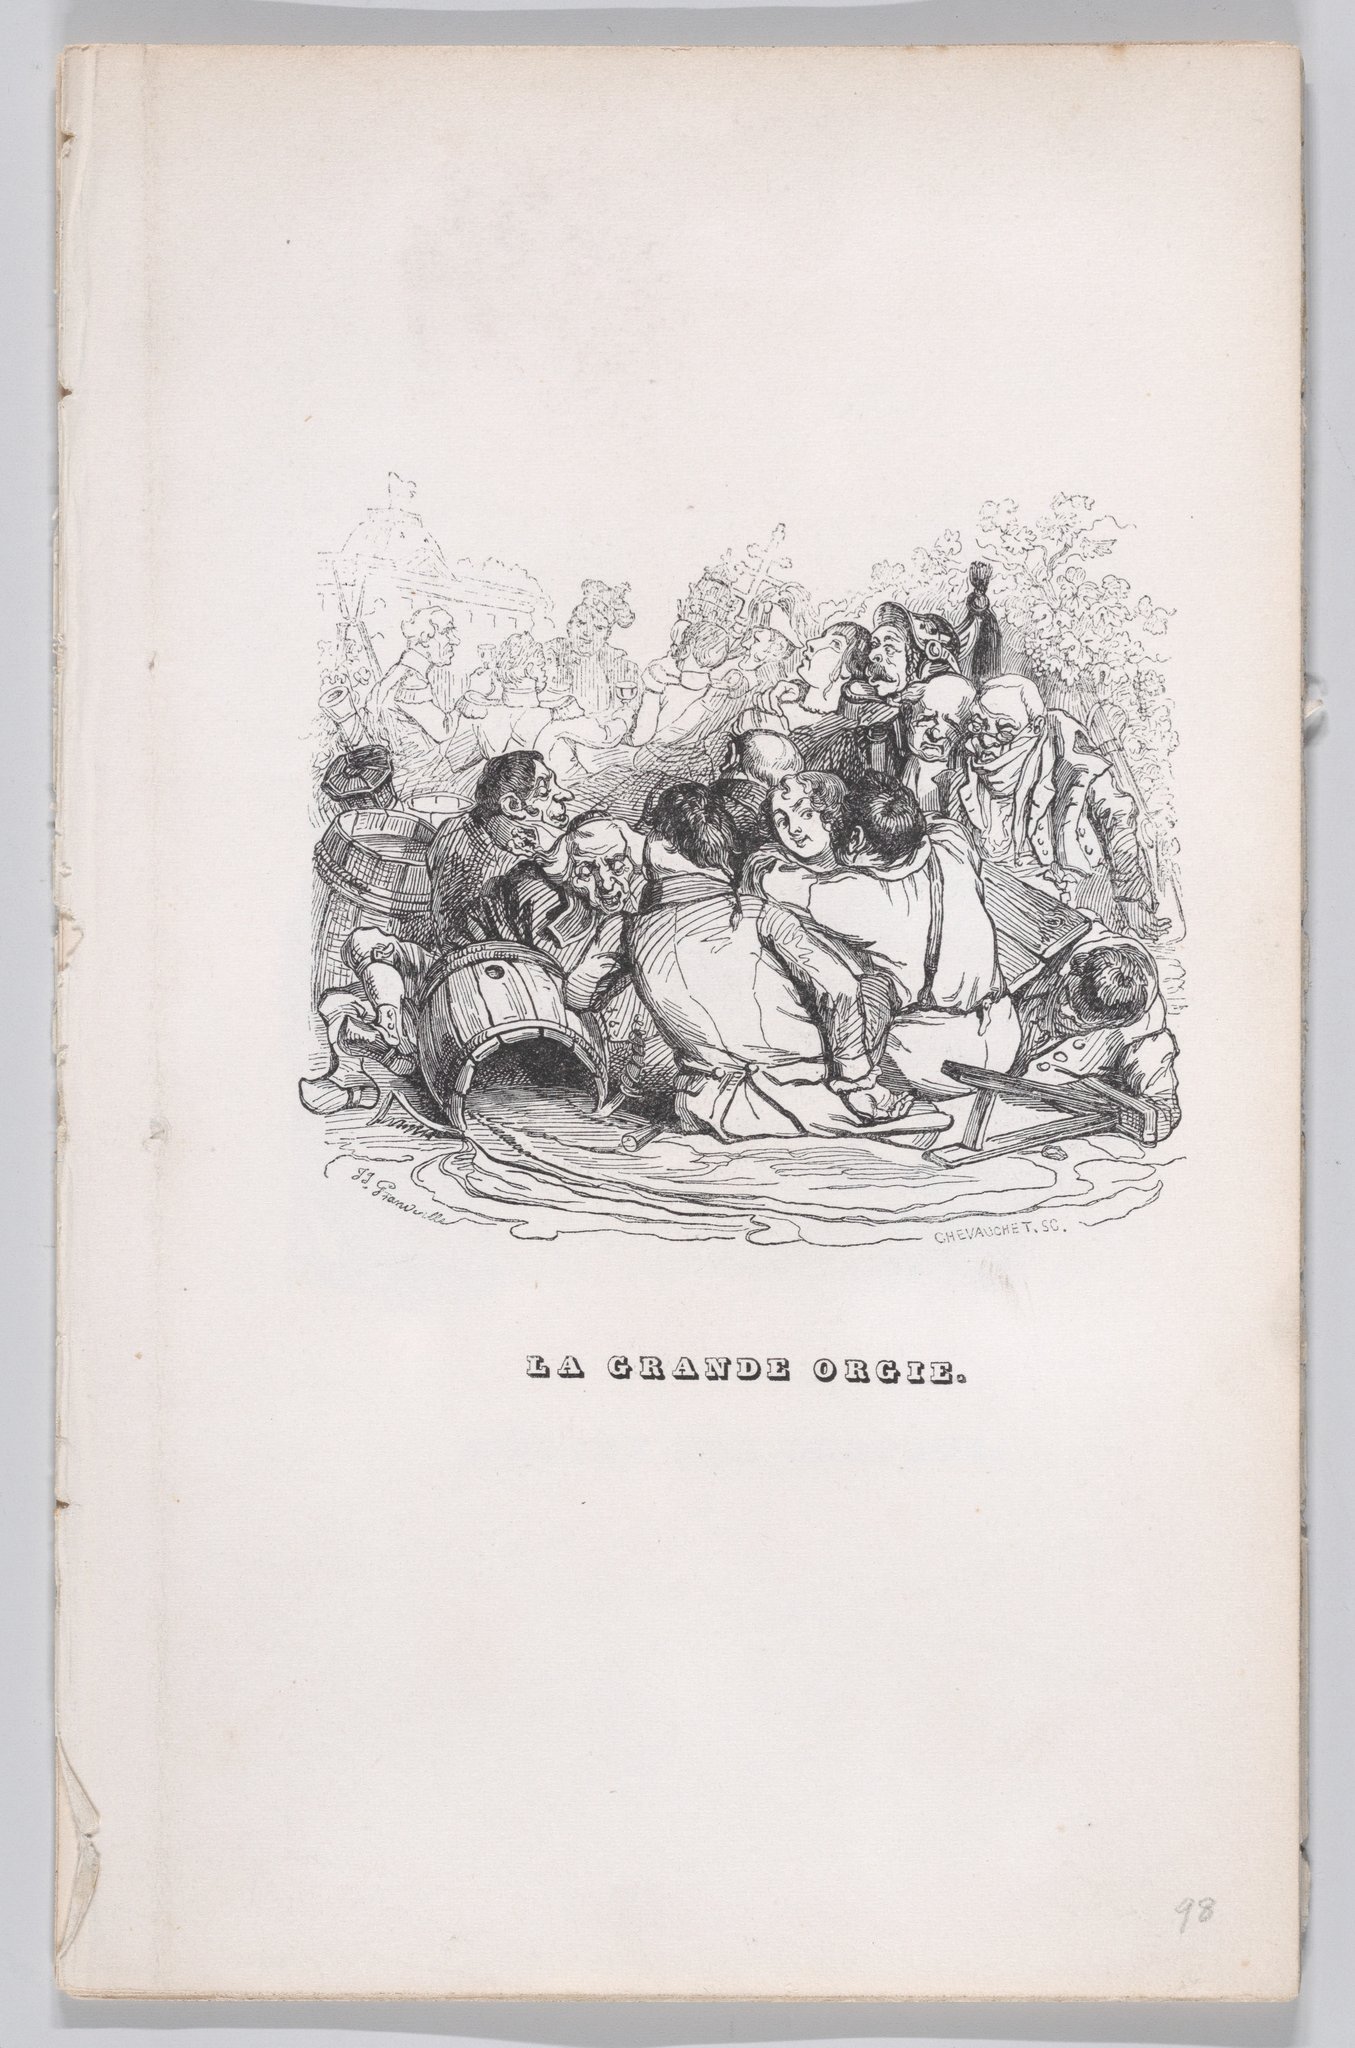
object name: print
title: The Big Orgy, from "The Complete Works of Béranger"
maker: j. j. grandville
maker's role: illustrator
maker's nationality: french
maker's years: 1803-1847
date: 1836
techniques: engraving